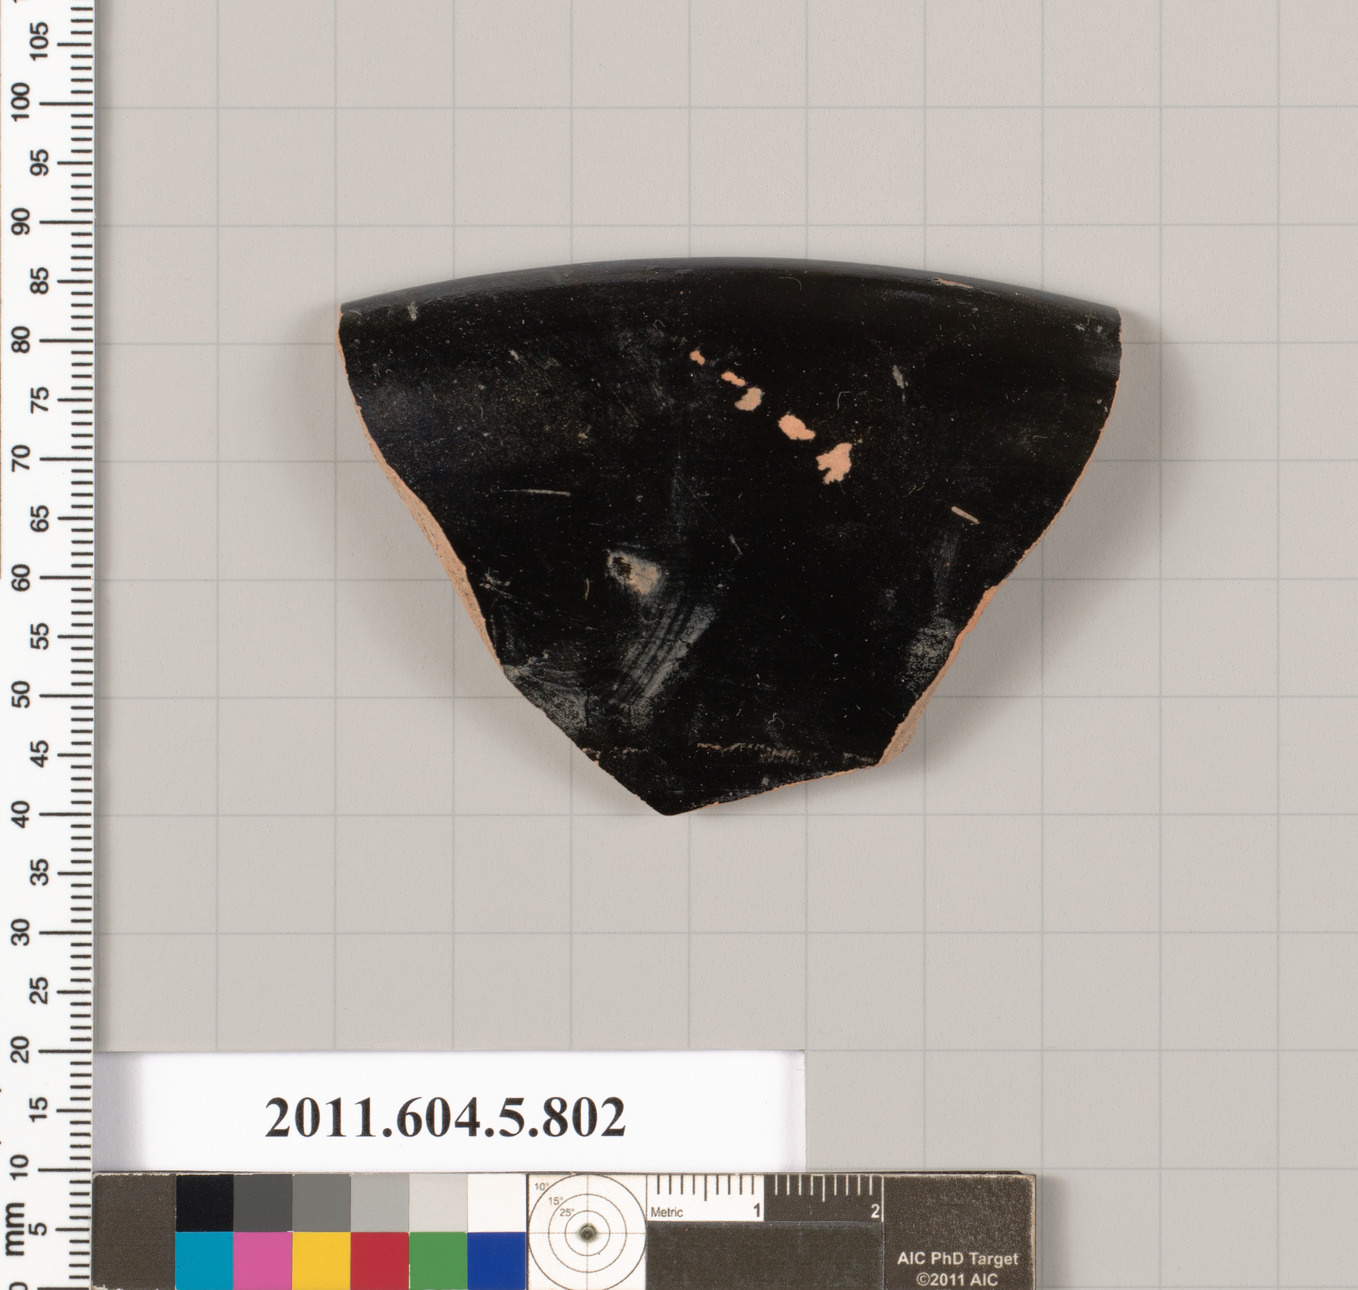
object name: kylix fragment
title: Terracotta rim fragment of a kylix (drinking cup)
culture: greek, attic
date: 600-401 BCE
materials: terracotta